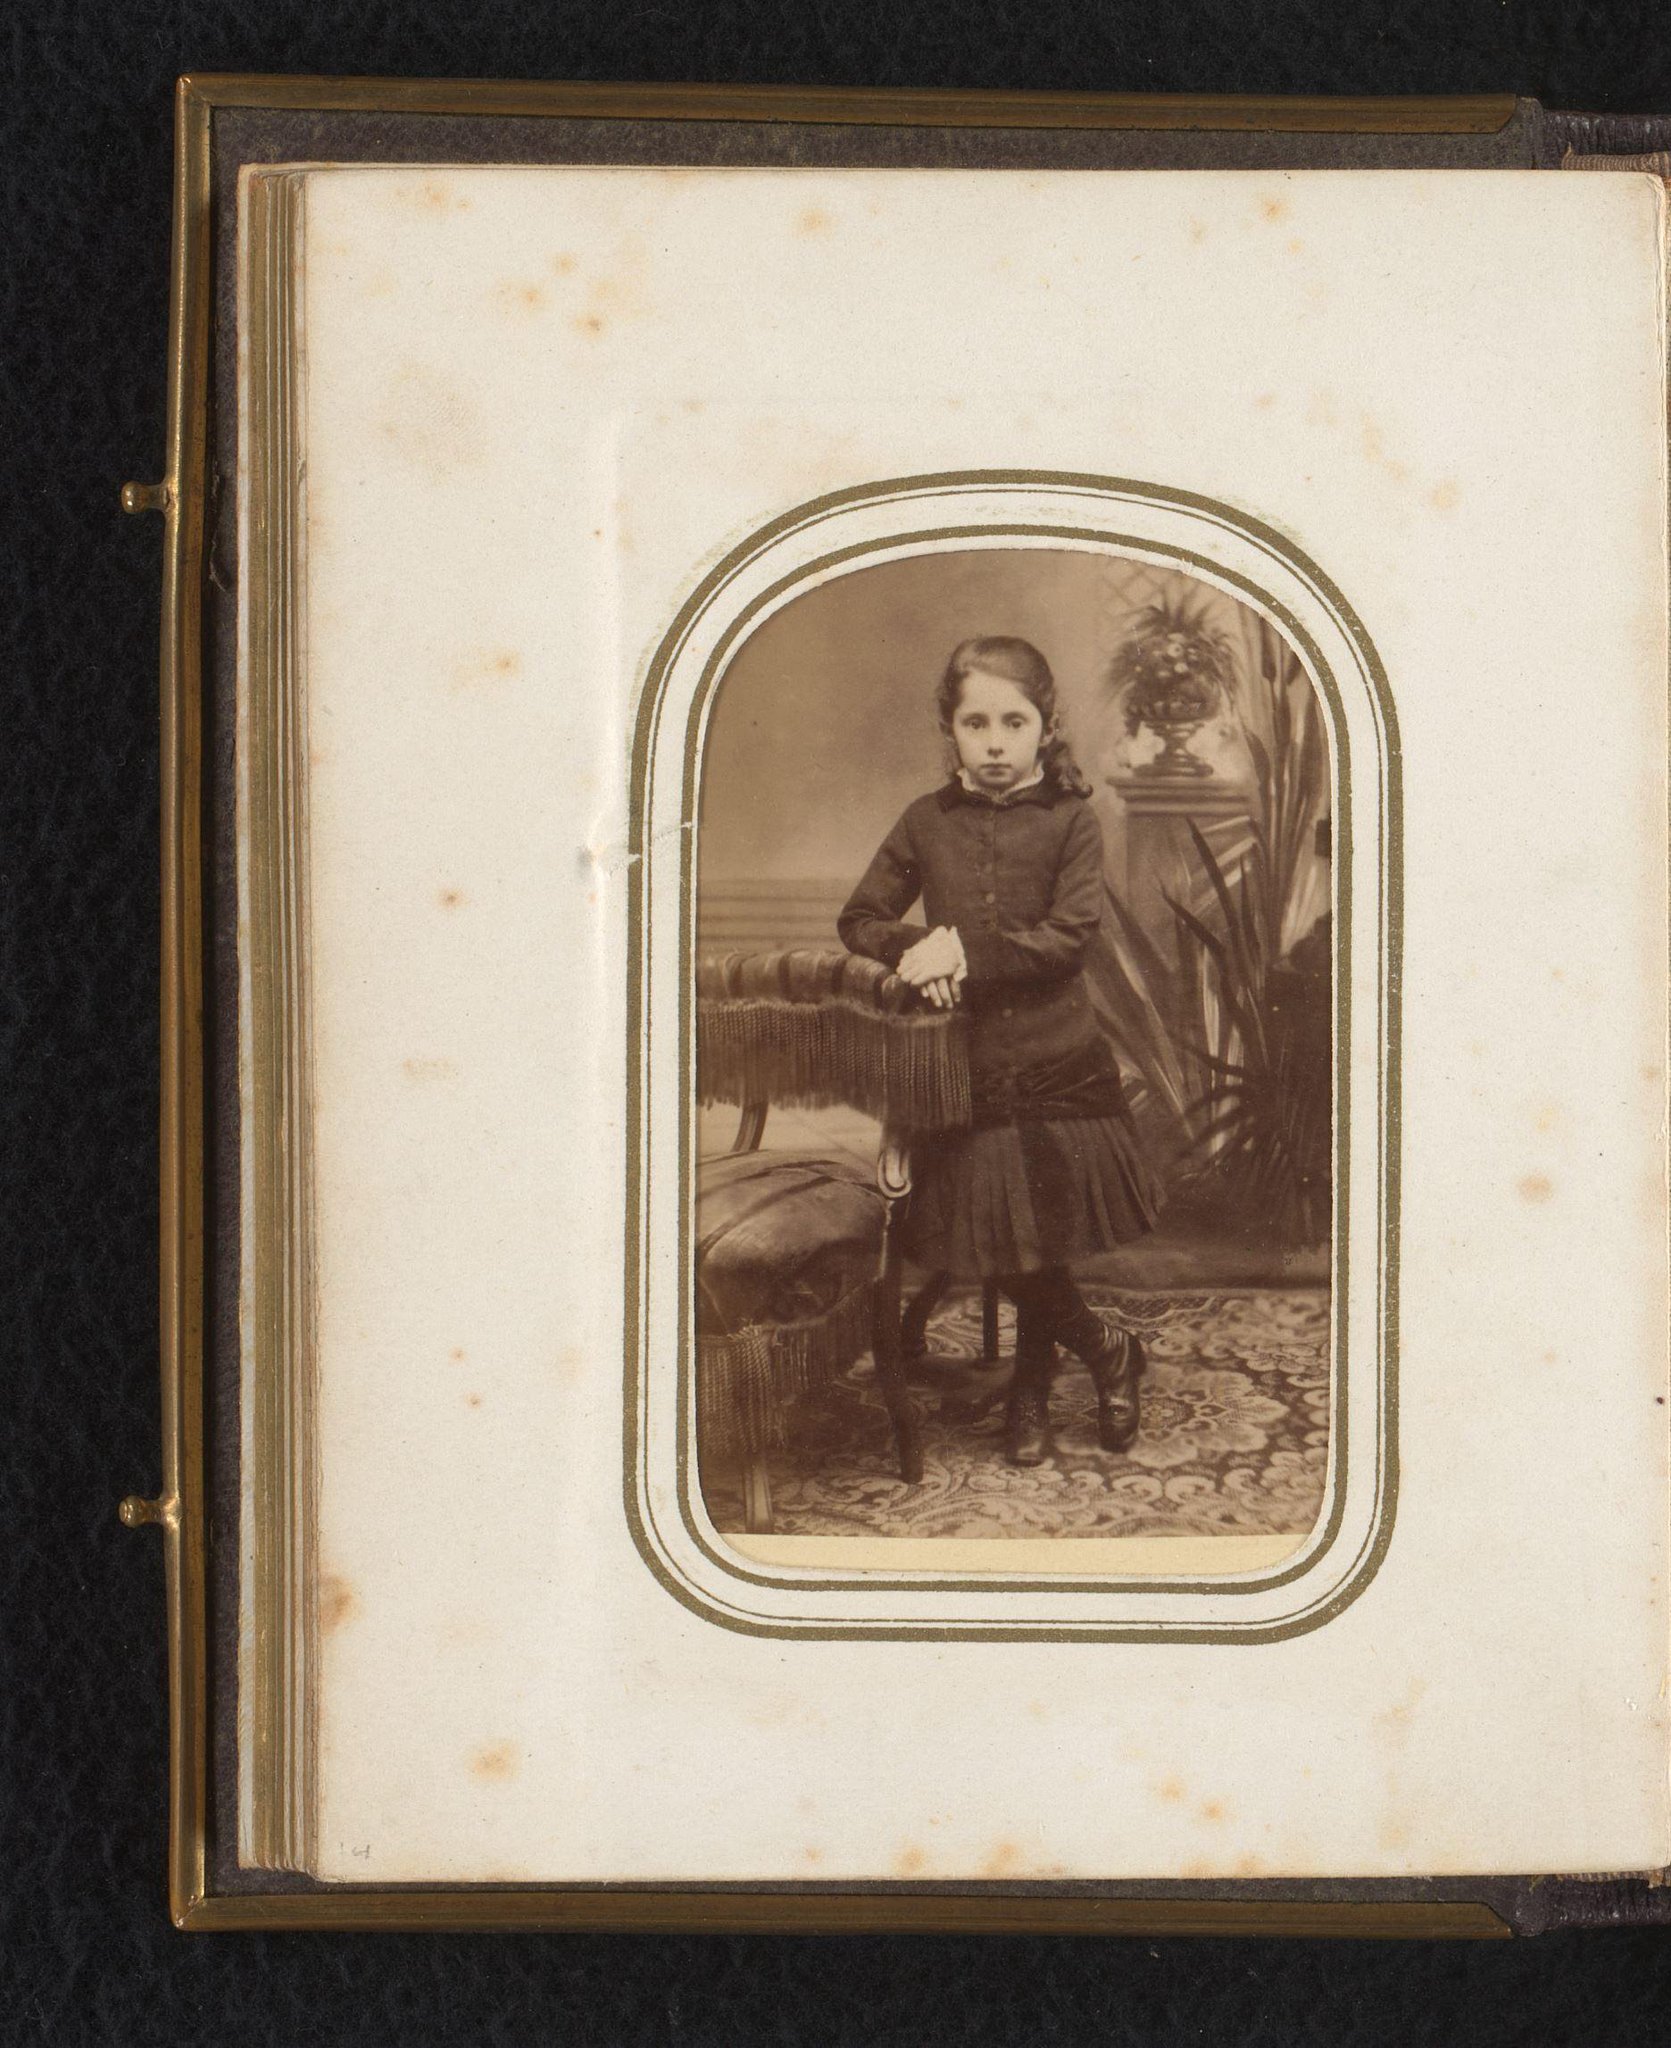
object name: carte de visite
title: Portret van een meisje bij een stoel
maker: veuve j. van koningsveld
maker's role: fotograaf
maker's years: 1828-1907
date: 1868-1884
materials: cardboard, photographic support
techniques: albumen print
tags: historical persons, girl (child between toddler and youth), chair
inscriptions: inscription: ‘Wed. J. van Koningsveld/ Photographisch/ Atelier/ Deventer/ en Kampen (...)’